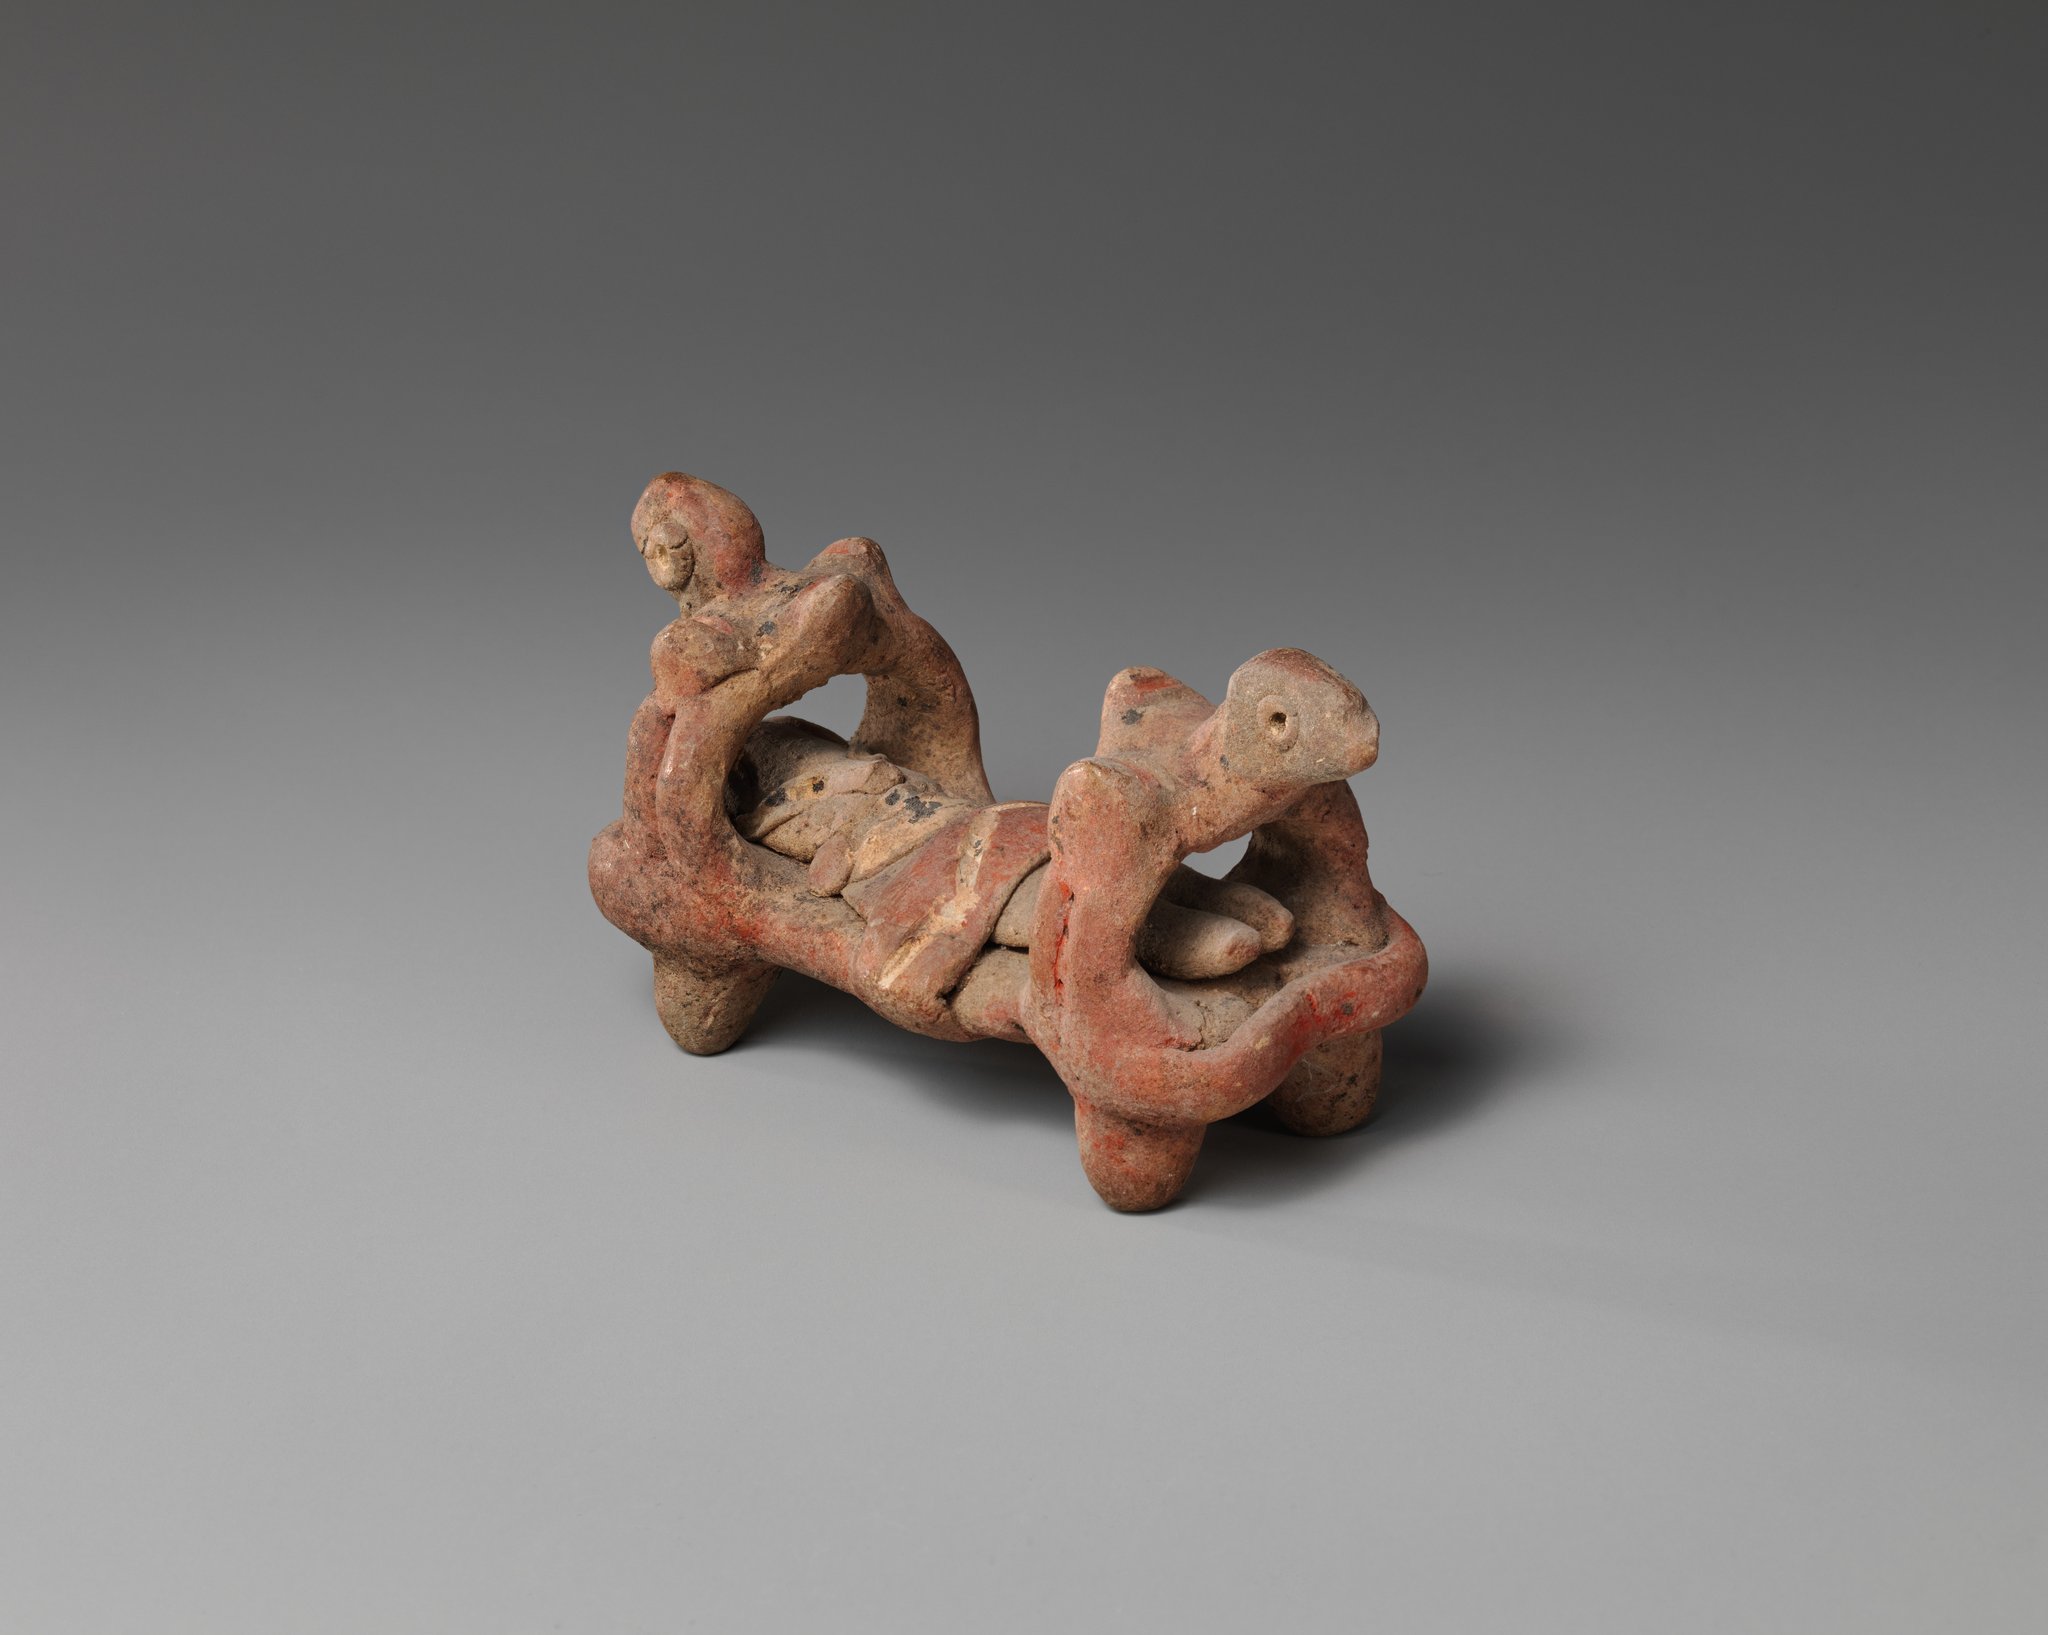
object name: figure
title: Bed Figure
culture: michoacan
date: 300 BCE-400 CE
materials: ceramic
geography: mexico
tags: human figures,birds